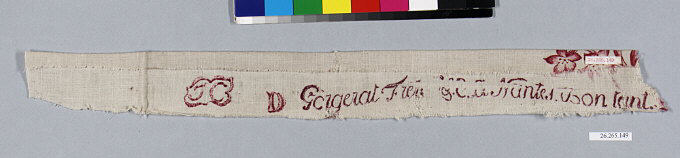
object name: piece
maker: gorgerat frères et cie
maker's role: manufactory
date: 1791-1815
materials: cotton